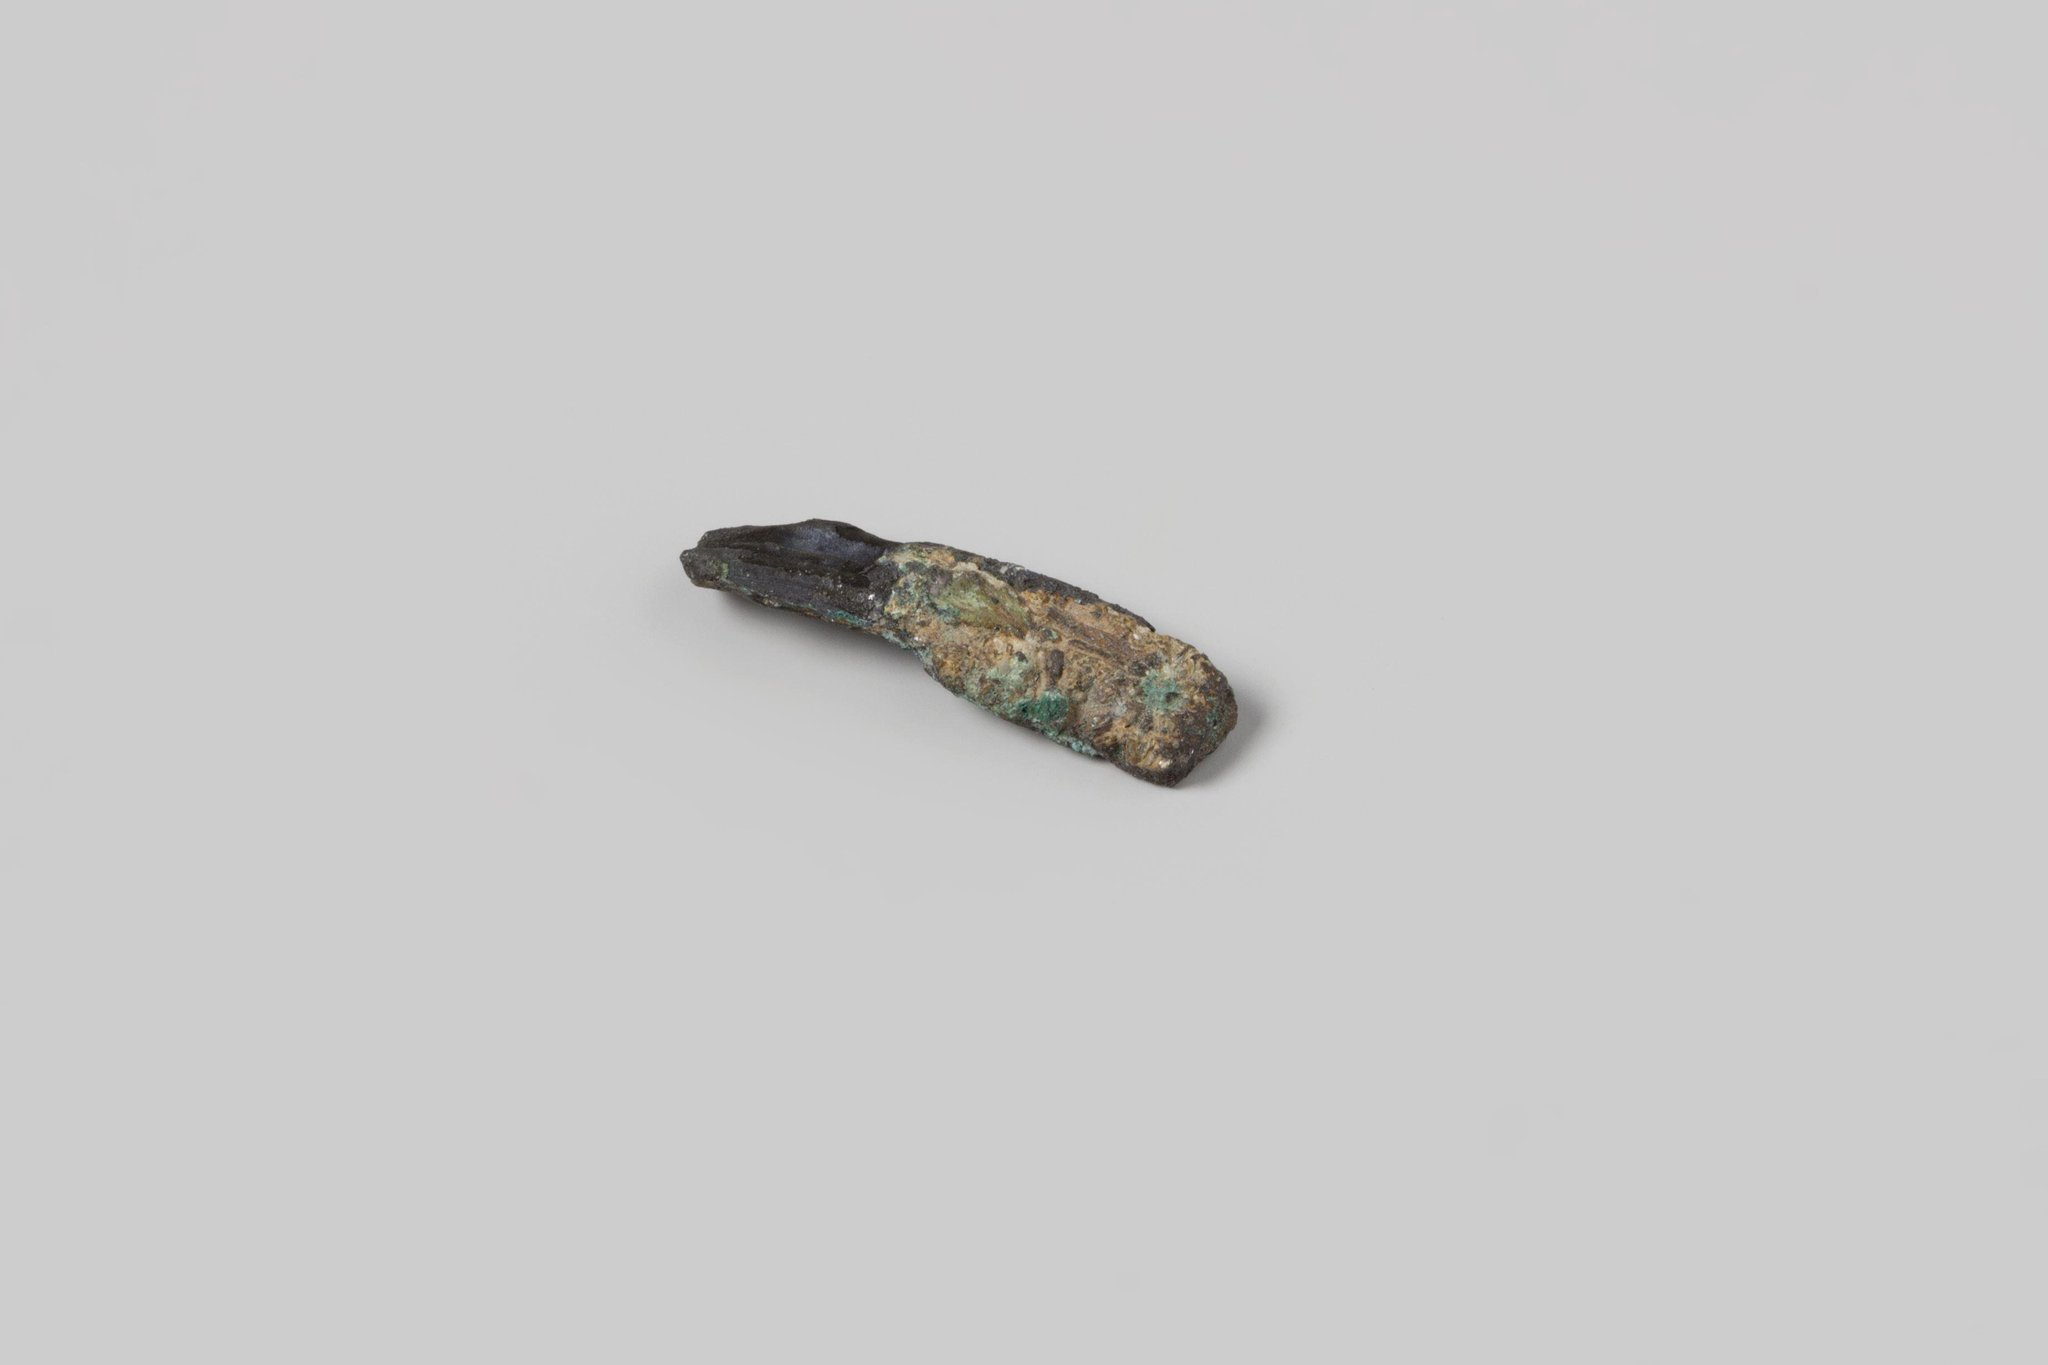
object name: verpakking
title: Fragment montuur van een verpakking uit het wrak van de Oost-Indiëvaarder Hollandia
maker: Anonymous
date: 1700-1743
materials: silver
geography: netherlands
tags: verenigde oostindische compagnie, hollandia (schip), annet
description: Container, rim; fragm, id. NG 1980-27H129, very eroded.